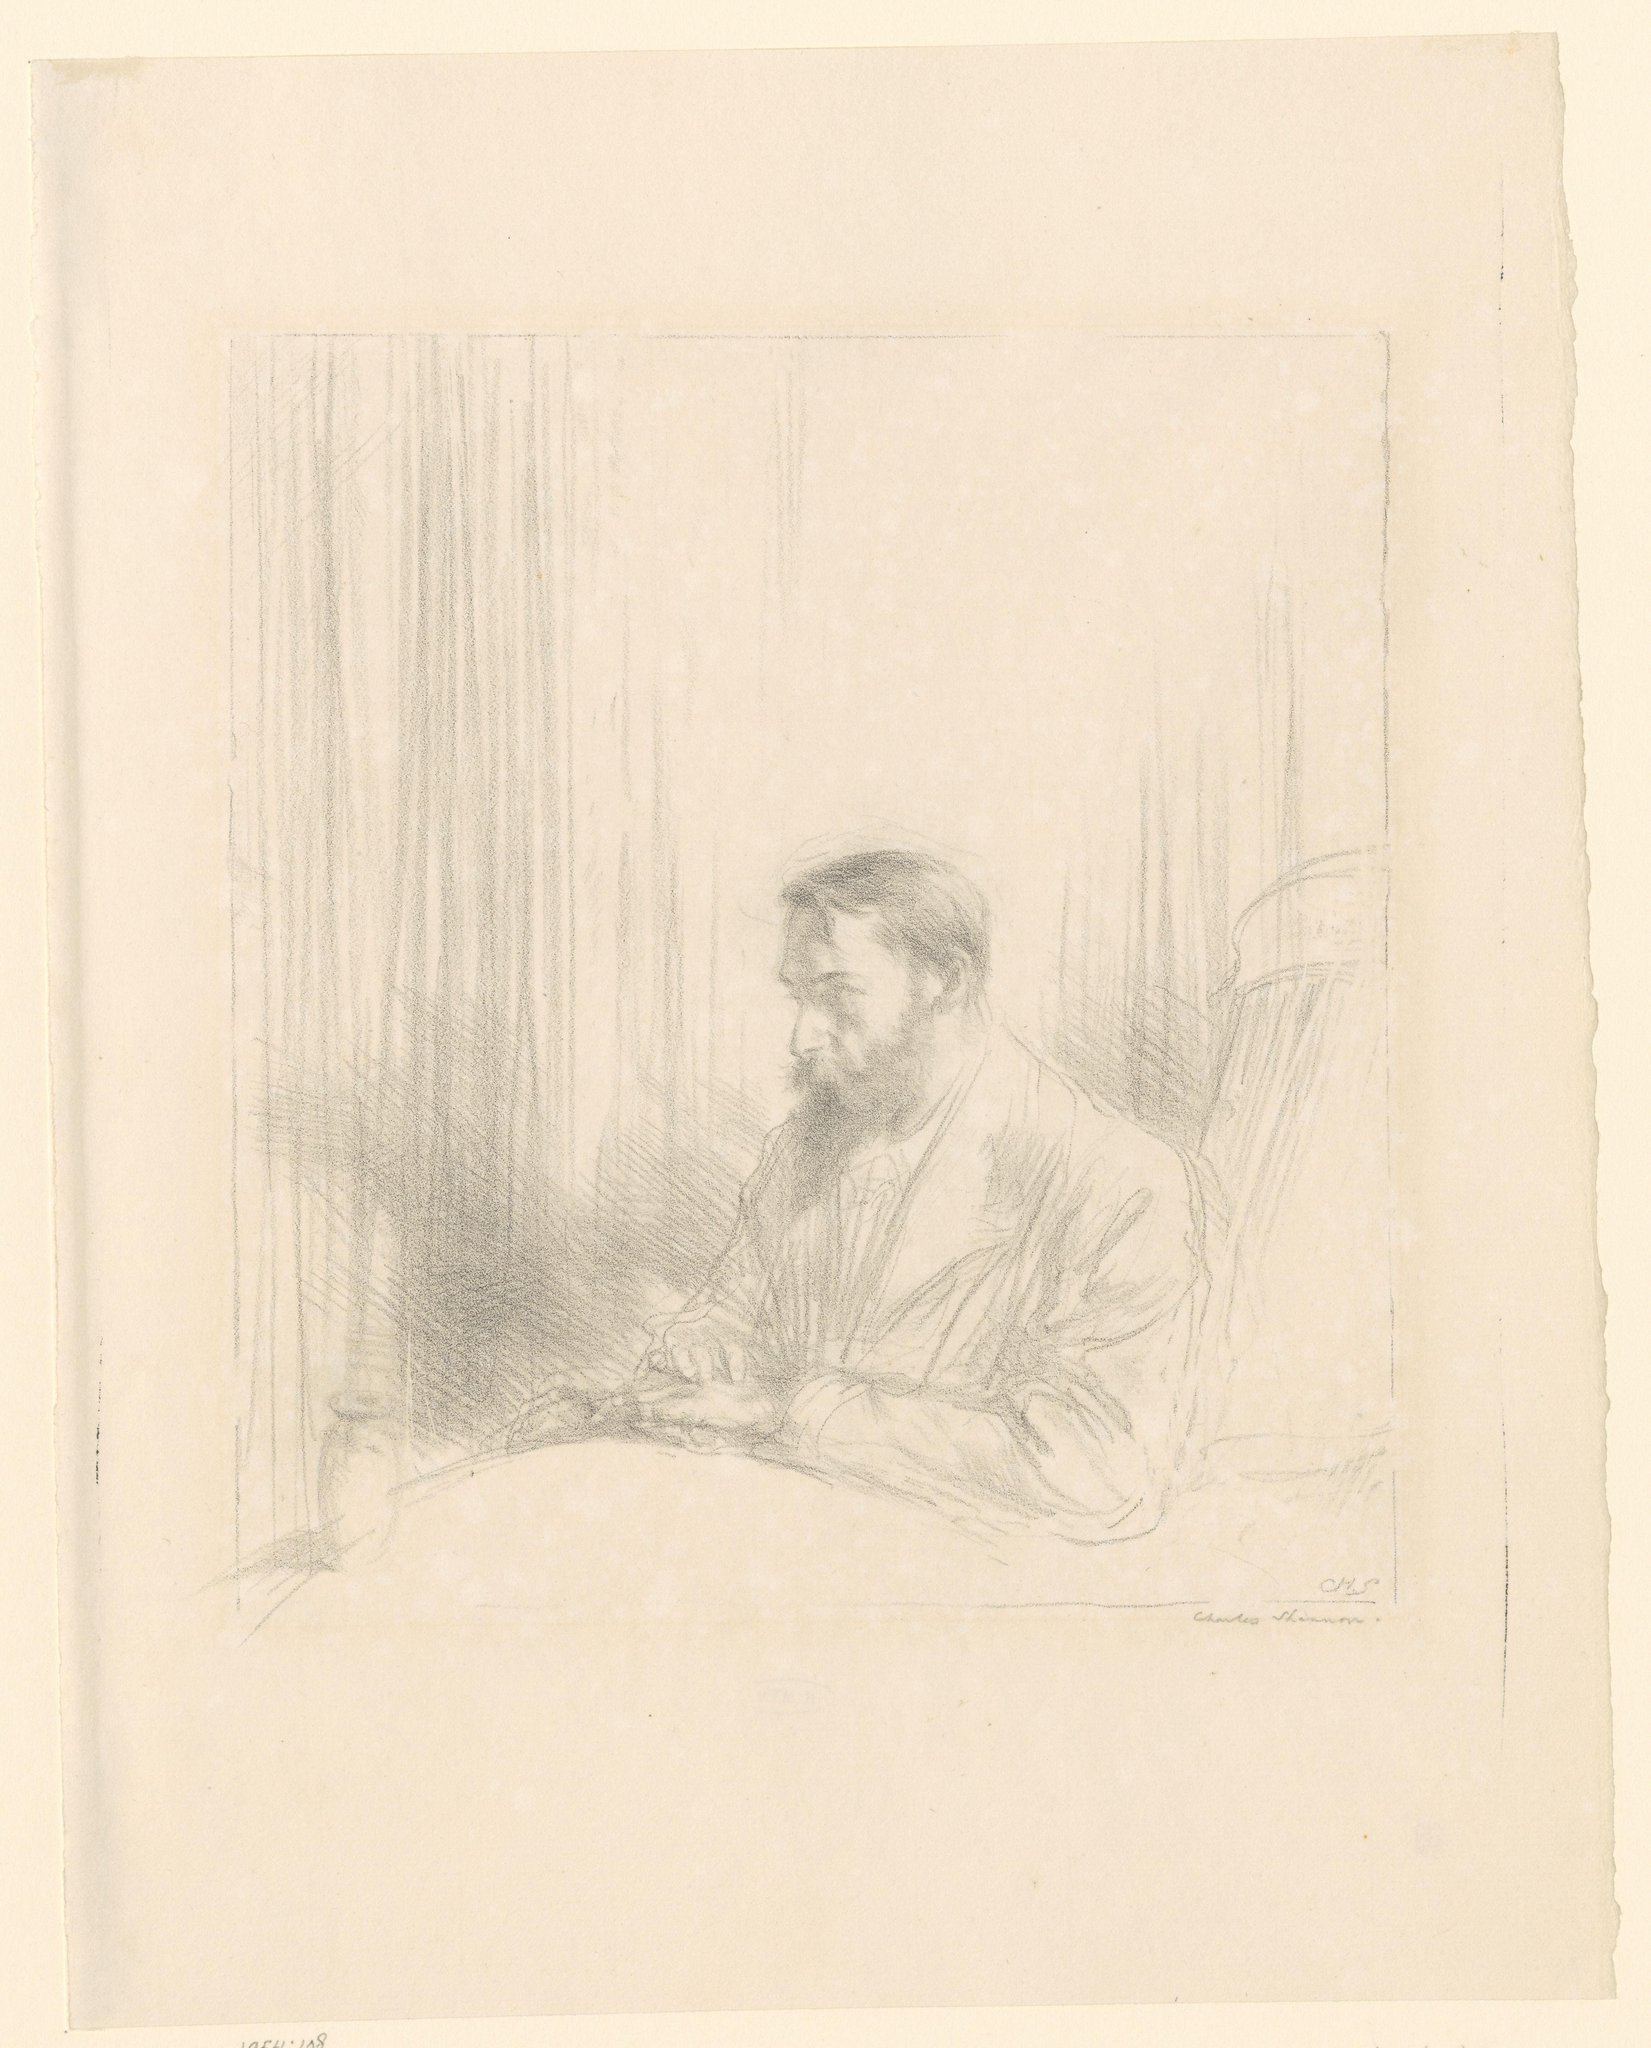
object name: print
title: Portfolio nummer drie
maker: charles haslewood shannon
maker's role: draughtsman, print maker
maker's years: 1865-1937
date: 1895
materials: paper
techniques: lithograph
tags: elbert jan van wisselingh, adult man, historical persons, table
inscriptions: collector's mark: Lugt 2228